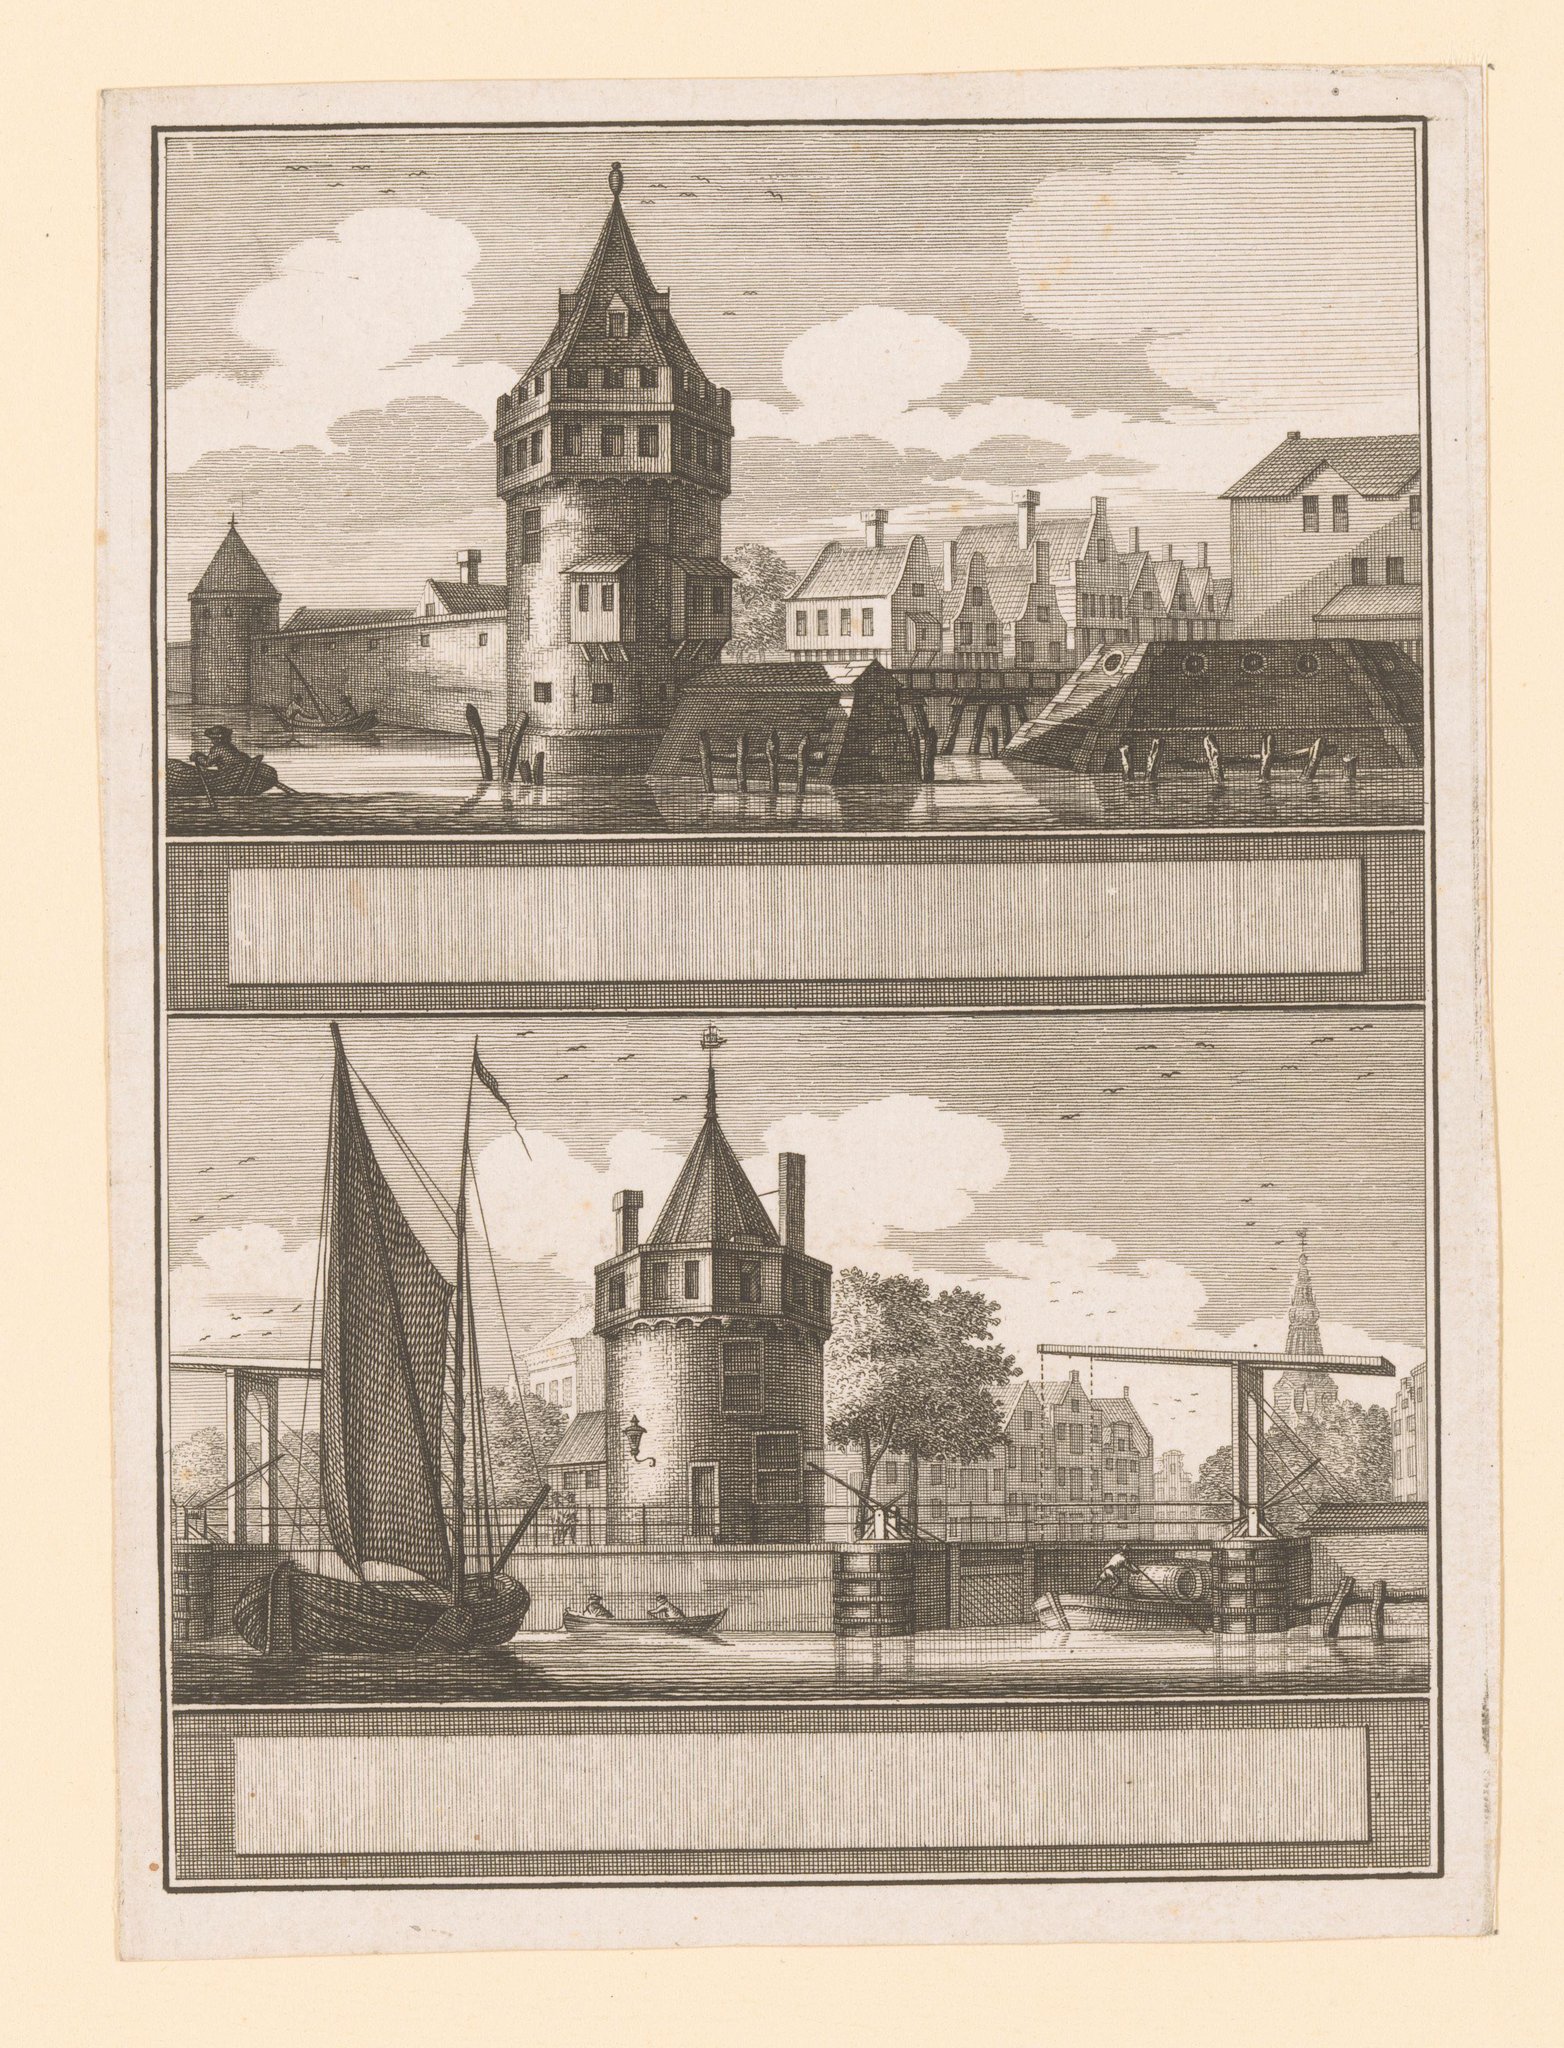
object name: book illustration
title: Twee gezichten op de Schreierstoren in Amsterdam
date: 1782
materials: paper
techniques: engraving, etching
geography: amsterdam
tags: urban housing, sailing-ship, sailing-boat, towers ~ fortified city, rowing-boat, canoe, etc., bridge in city across river, canal, etc.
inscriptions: date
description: Proefdruk voor de letter voor de prent uit: De maandelykse Nederlandsche Mercurius (...), 52 (1782), p. 182.